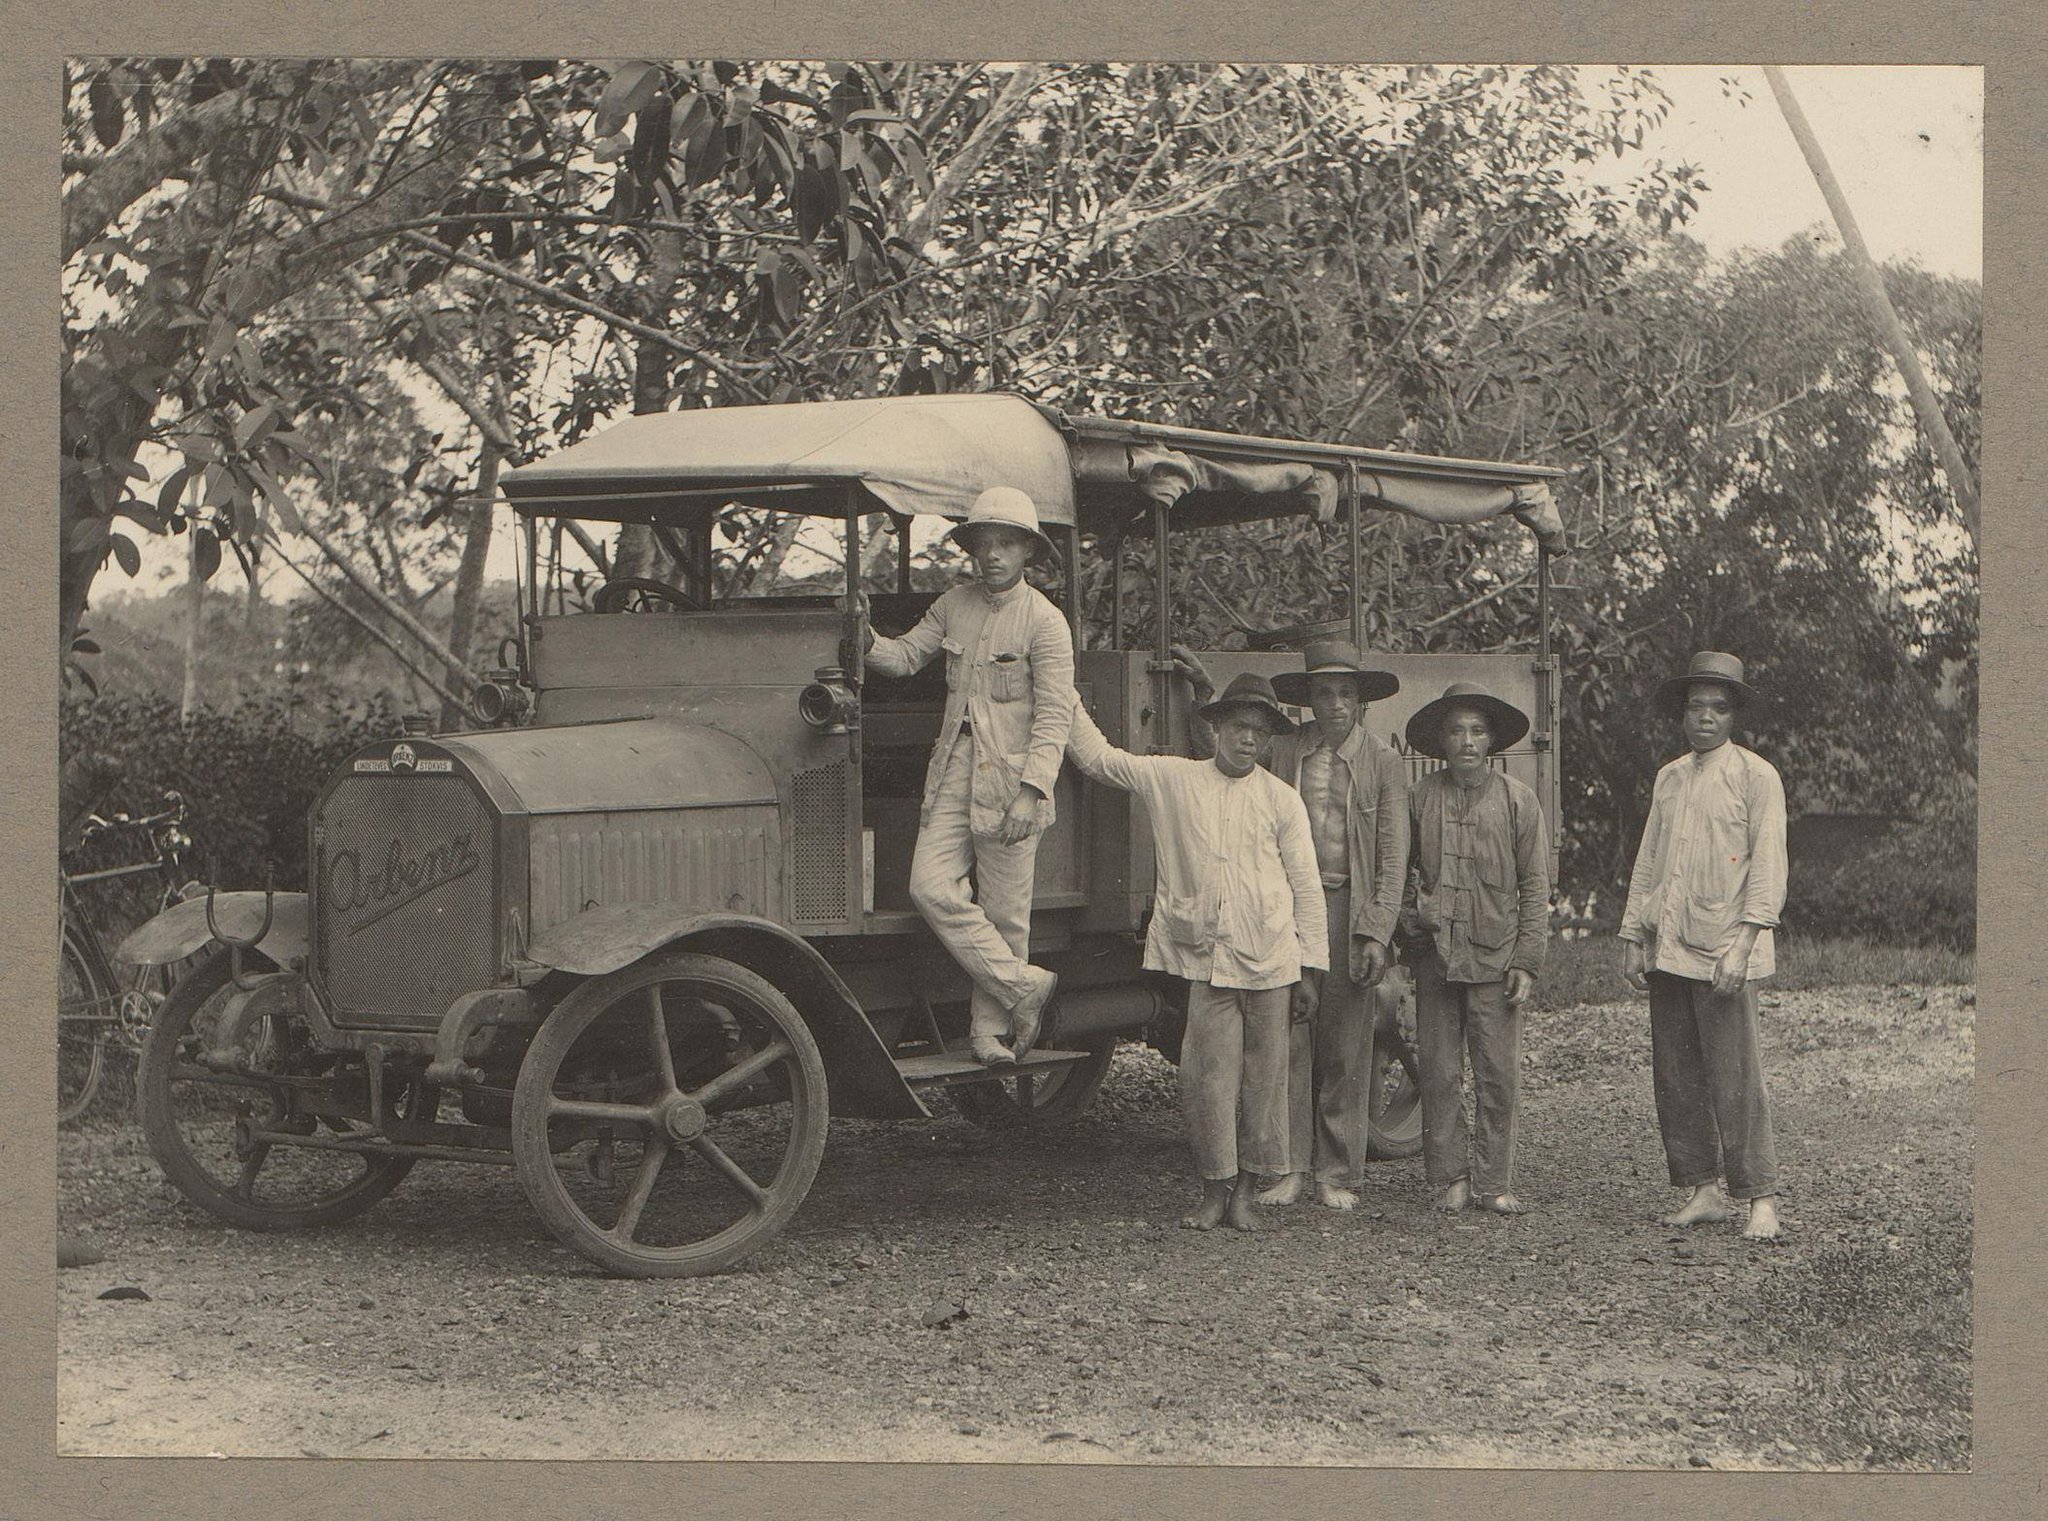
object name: photograph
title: Arbenz vrachtauto in station te Batoe-Roessak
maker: Anonymous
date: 1914-1919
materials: photographic support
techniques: gelatin silver print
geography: bangka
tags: robert julius boers, truck, van, colonial system, mining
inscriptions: inscription: ‘Arbenz vrachtauto in station te Batoe-Roessak’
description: Chauffeur en enkele mannen poserend bij de Arbenz vrachtauto van de Banka-tinwinning te Baturusa bij Merawang. Onderdeel van het fotoalbum aangeboden aan Robert Julius Boers bij zijn vertrek naar Nederland in 1919 door het personeel van de Banka-tinwinning.